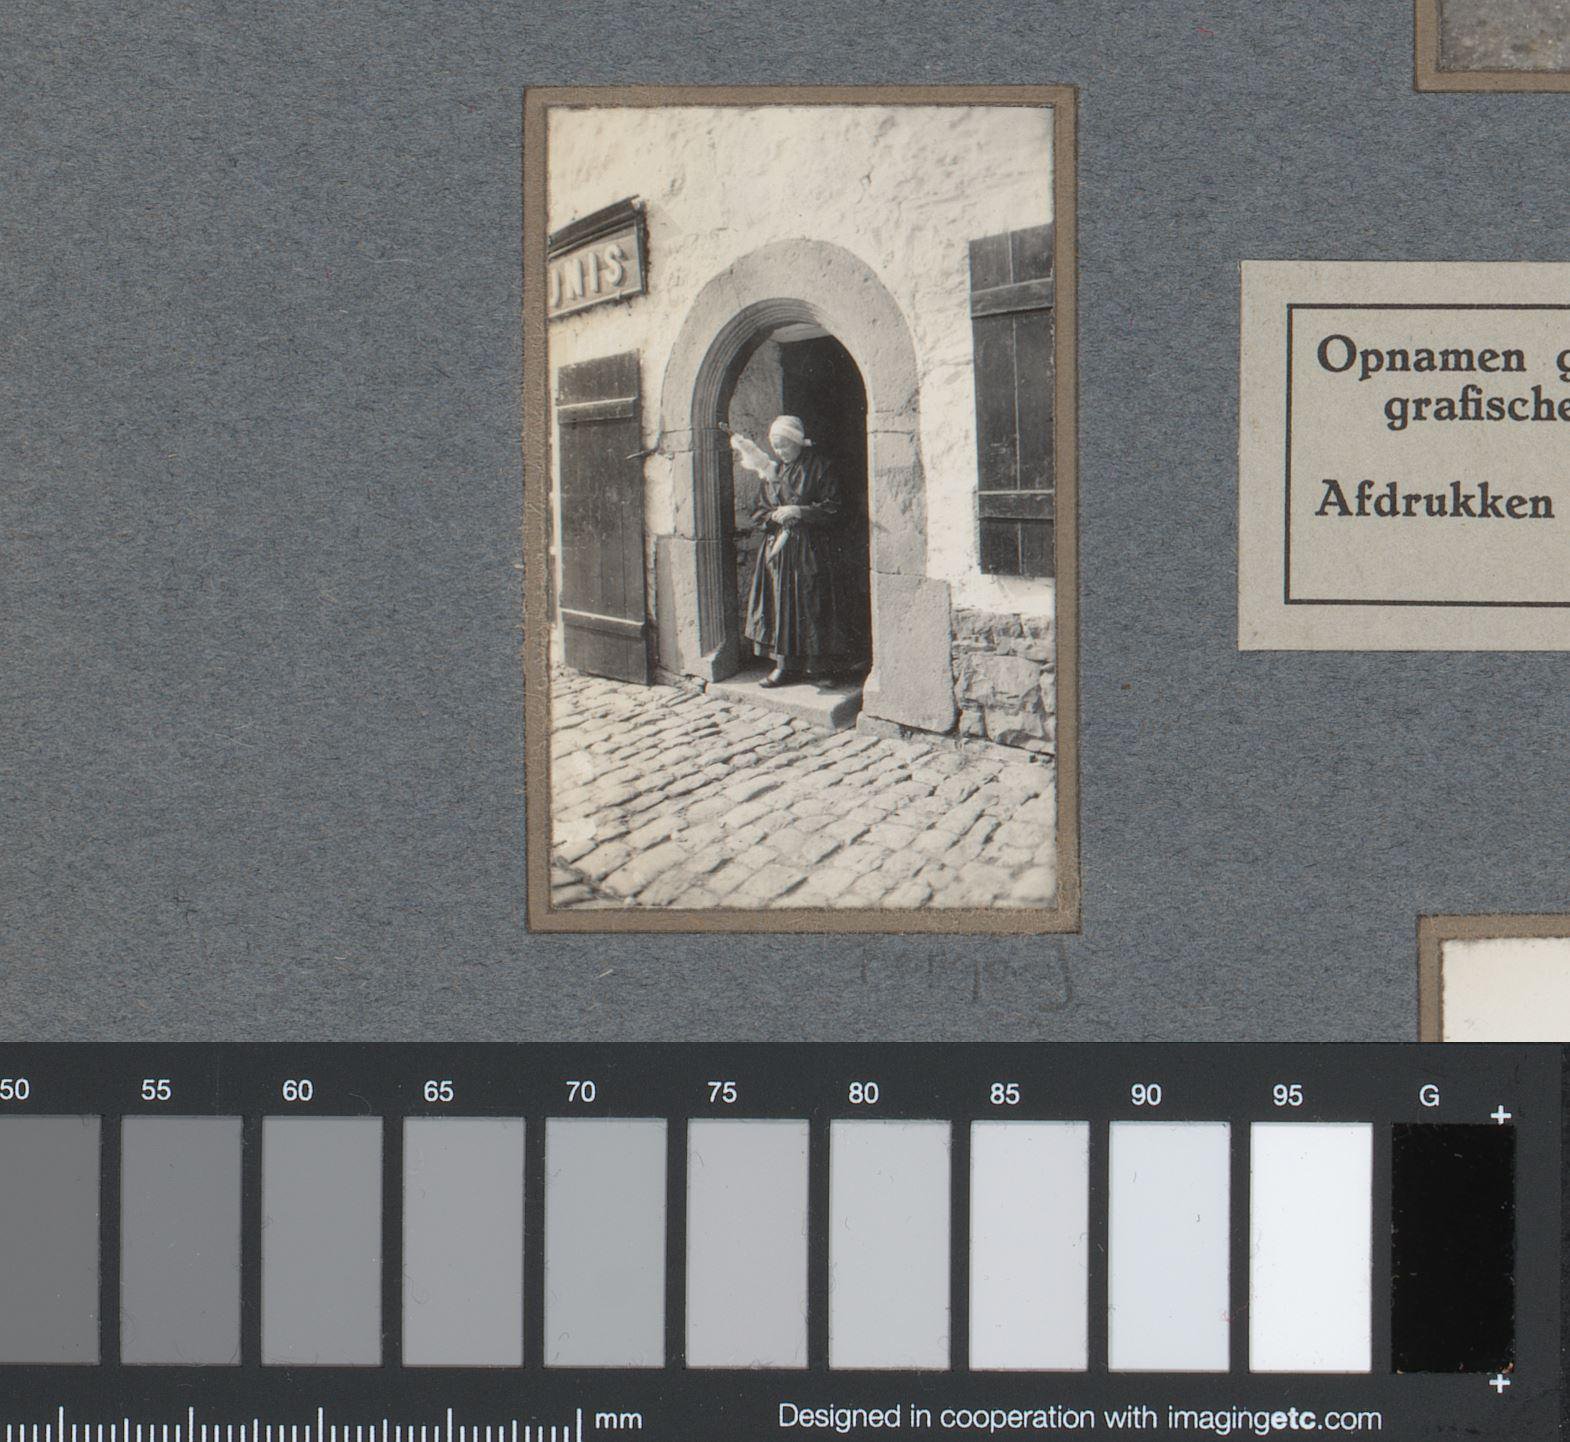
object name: album leaf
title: Oude vrouw met spintol in een deuropening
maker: Anonymous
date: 1925-1934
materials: photographic support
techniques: gelatin silver print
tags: spindle, old woman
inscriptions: inscription: ‘Opnamen gemaakt met de Autografische Vestzak-"Kodak"/ Model B./ Afdrukken gemaakt op "Velox" papier.’